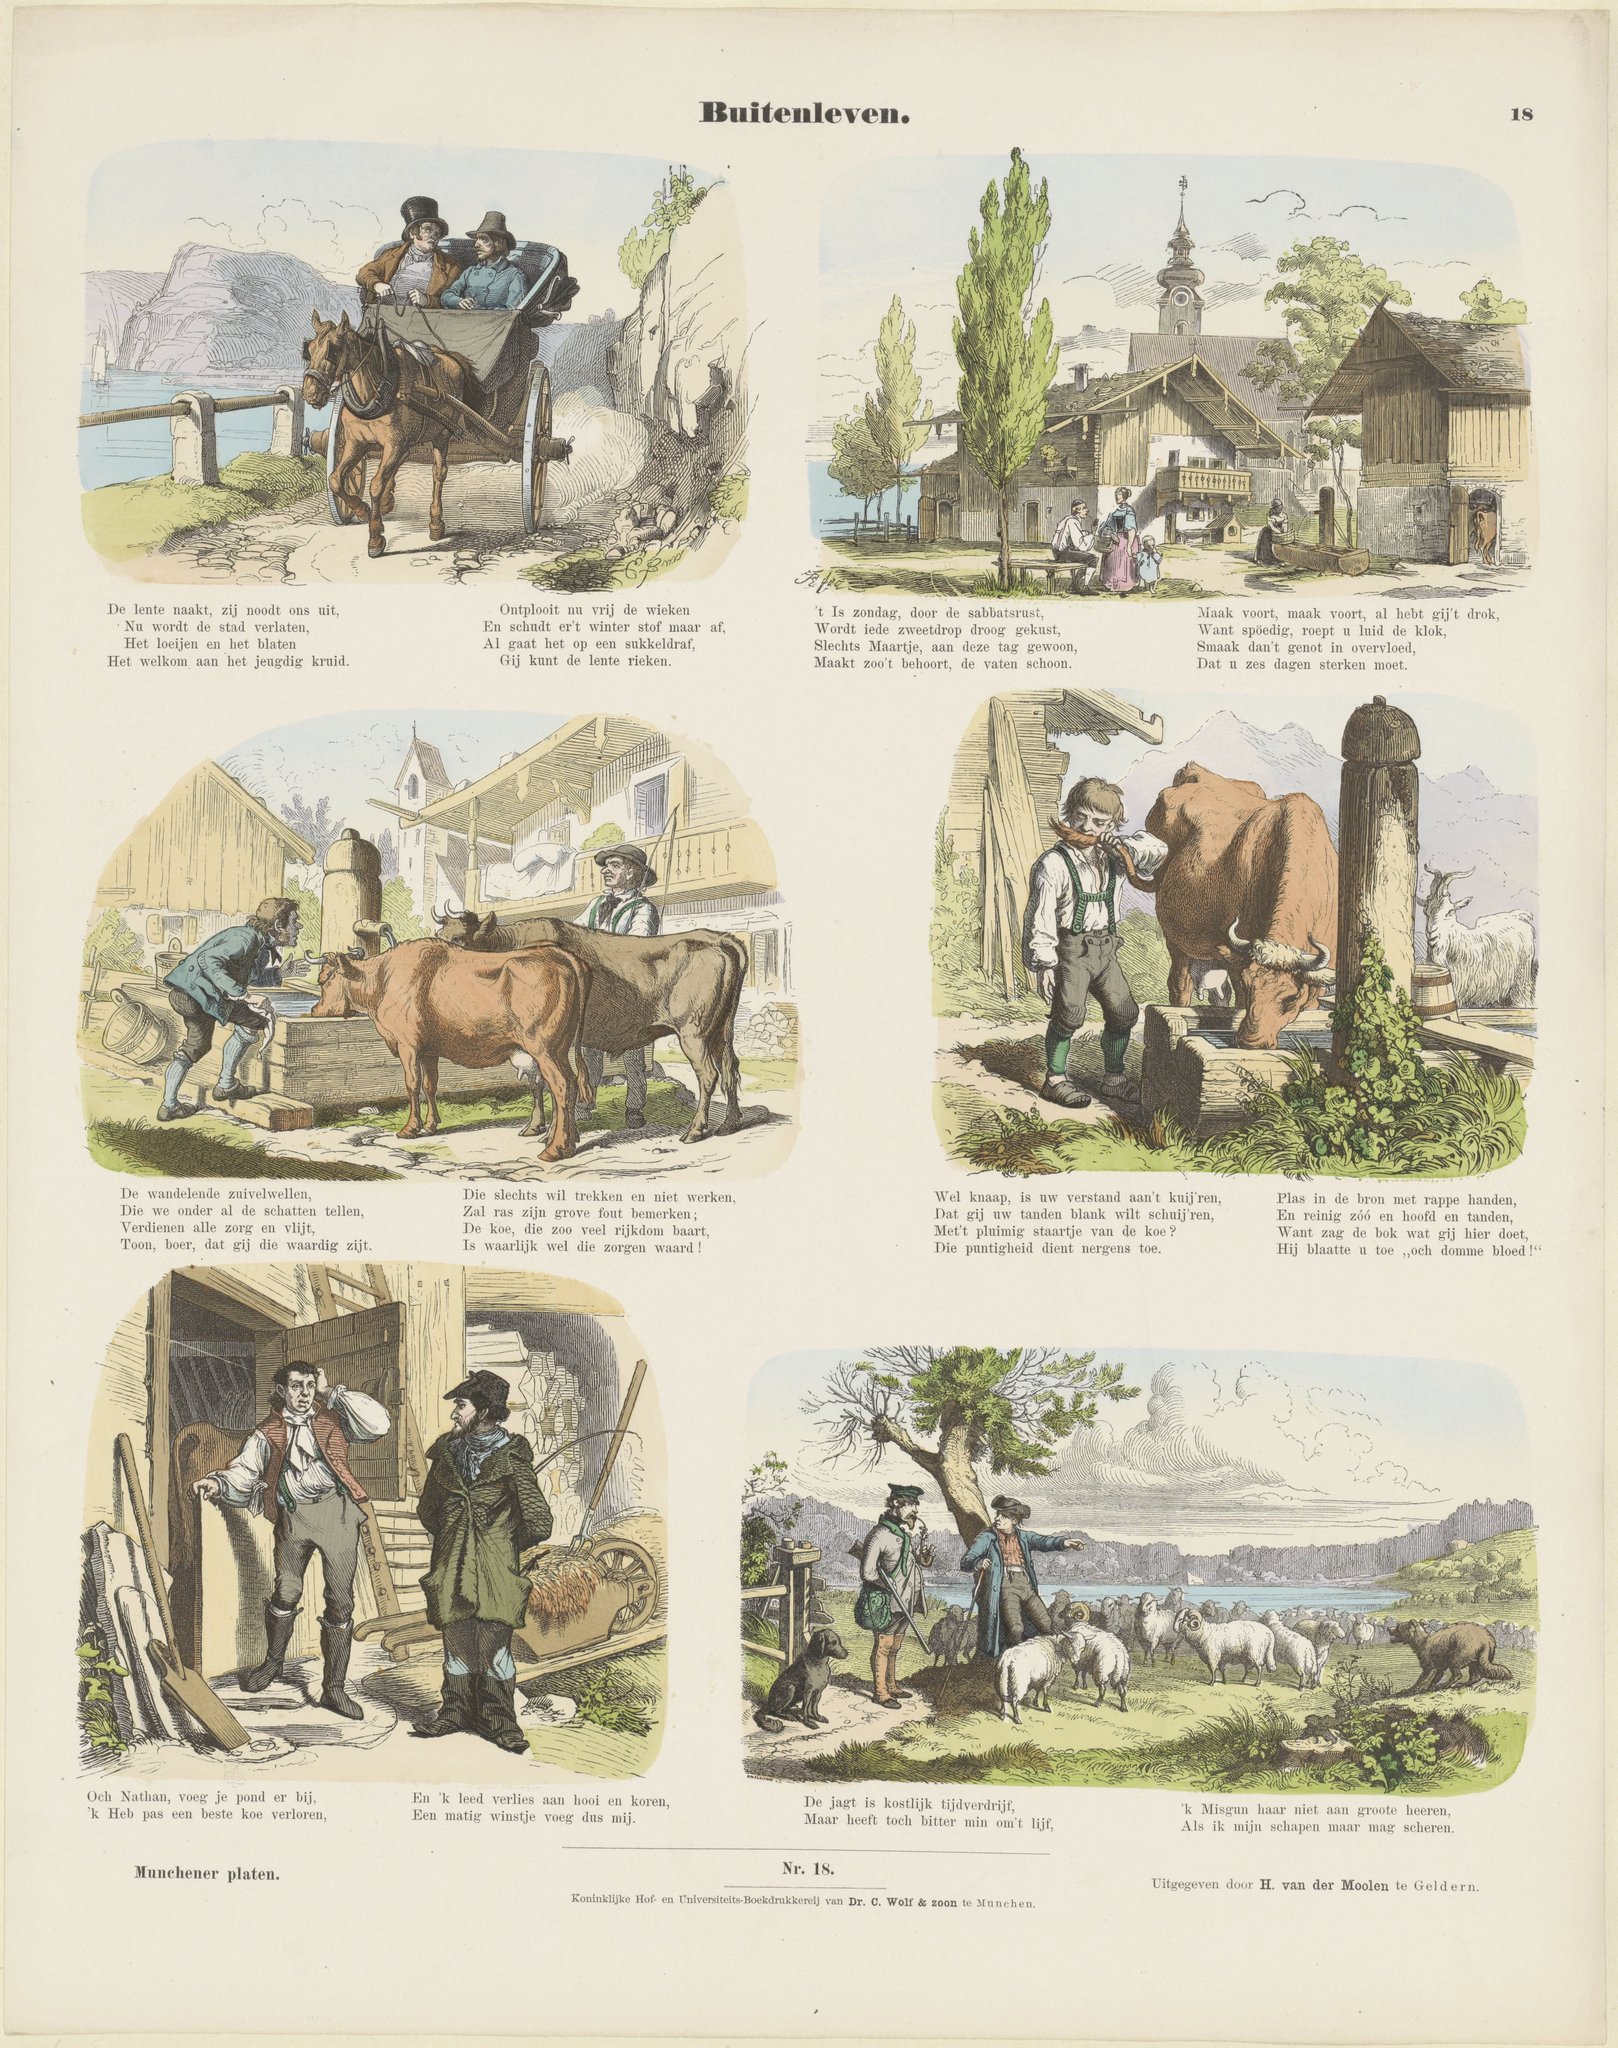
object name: print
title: Buitenleven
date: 1843-1920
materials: paper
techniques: colour, letterpress printing, engraving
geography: munich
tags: cow, herding, herdsman, herdswoman, shepherd, shepherdess, cowherd, etc., herd, flock, rural life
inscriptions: collector's mark: Lugt 2760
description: Blad met 6 voorstellingen van het buitenleven, waaronder twee mannen in een rijtuig in de natuur en een herder met zijn schapen in een weiland. Onder elke afbeelding een vers in twee kolommen. Genummerd midden onder: Nr. 18. Genummerd rechtsboven: 18.